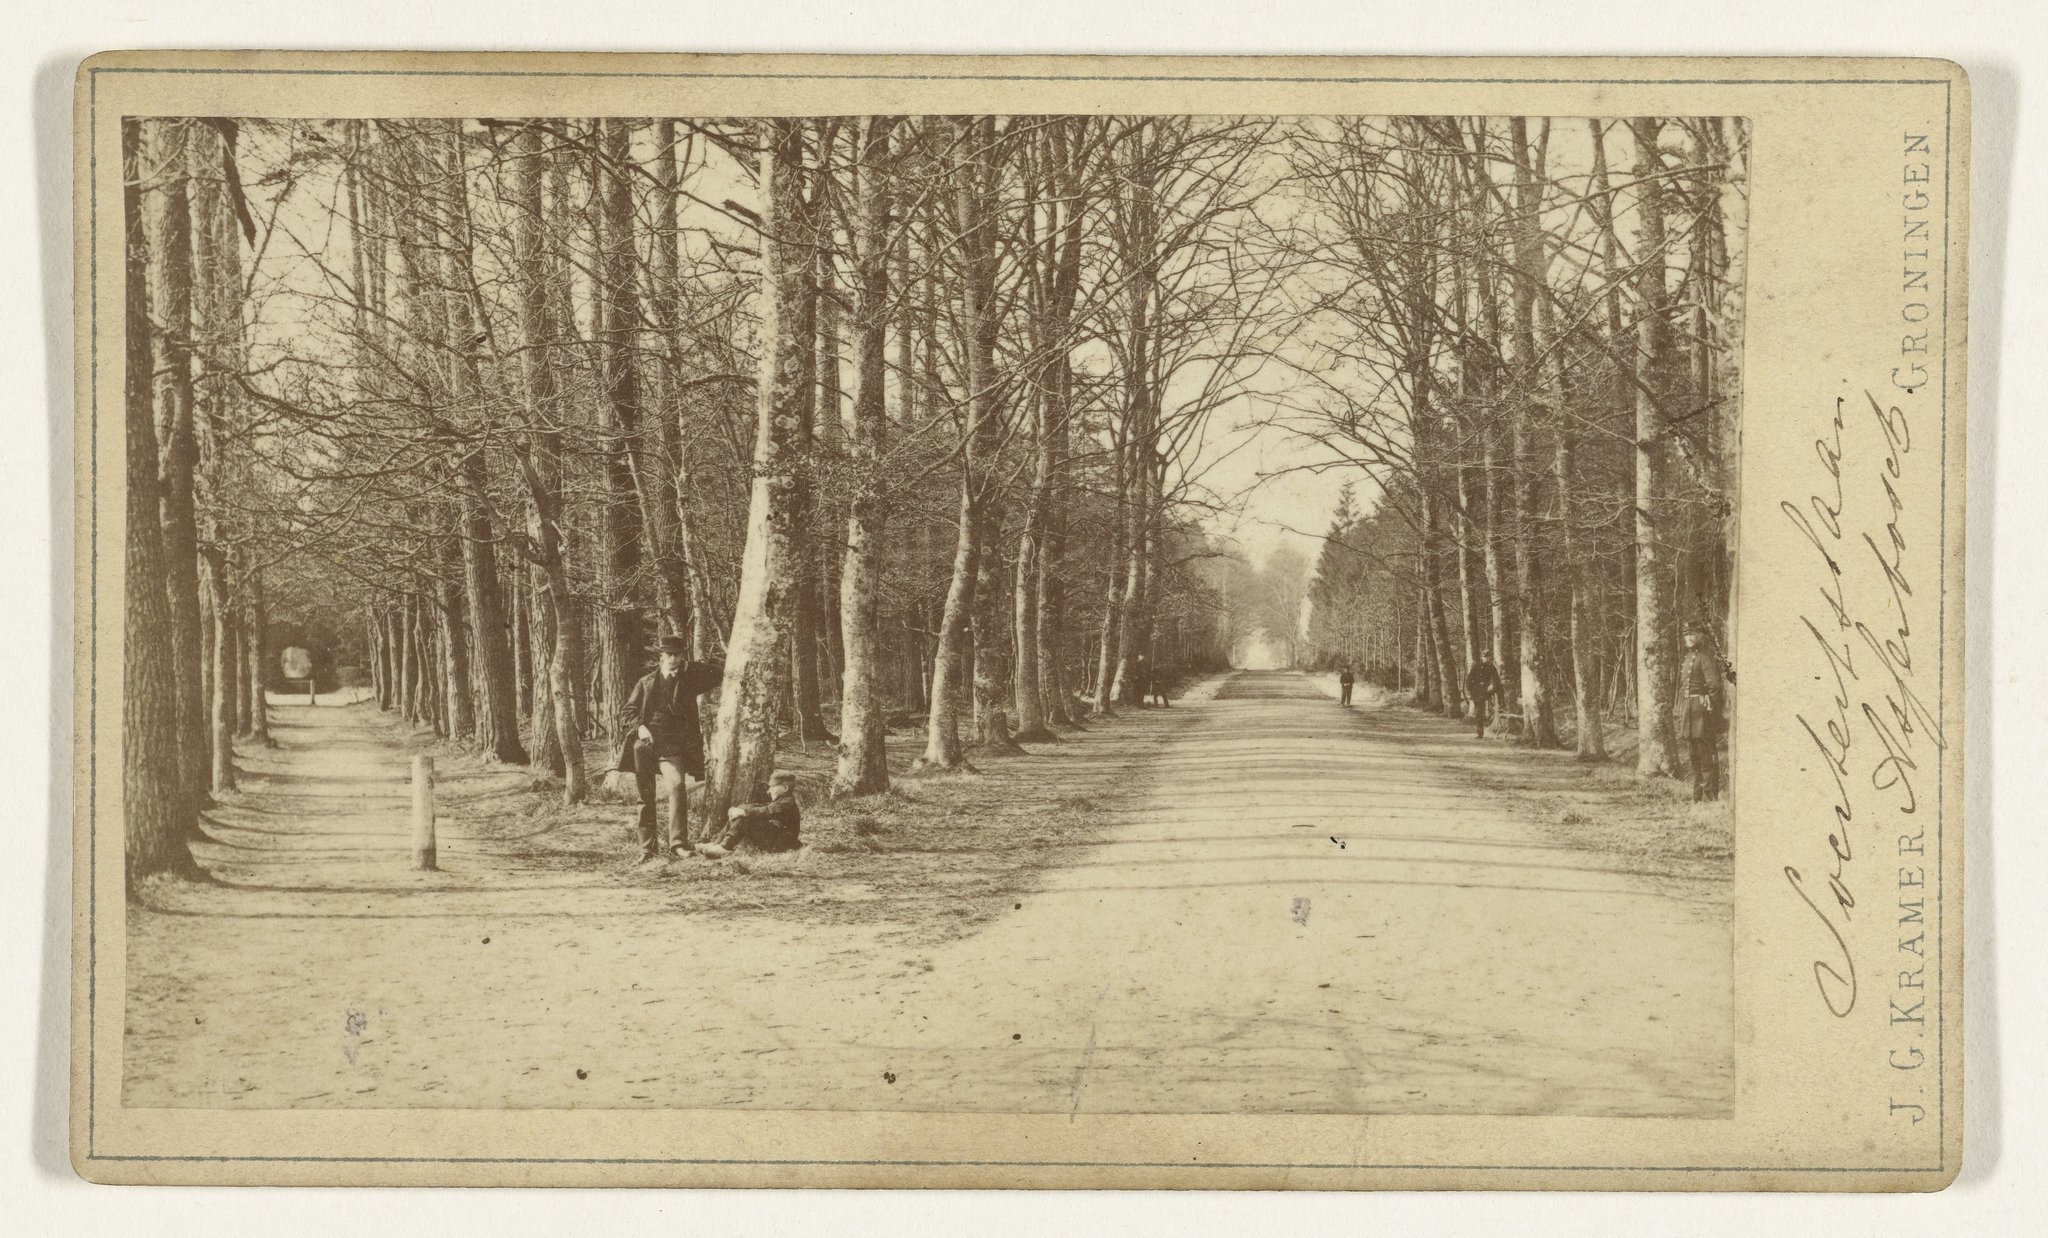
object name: photograph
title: Sociëteitslaan in het Asserbosch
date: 1878-1890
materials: cardboard, paper, photographic support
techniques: albumen print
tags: forest, wood